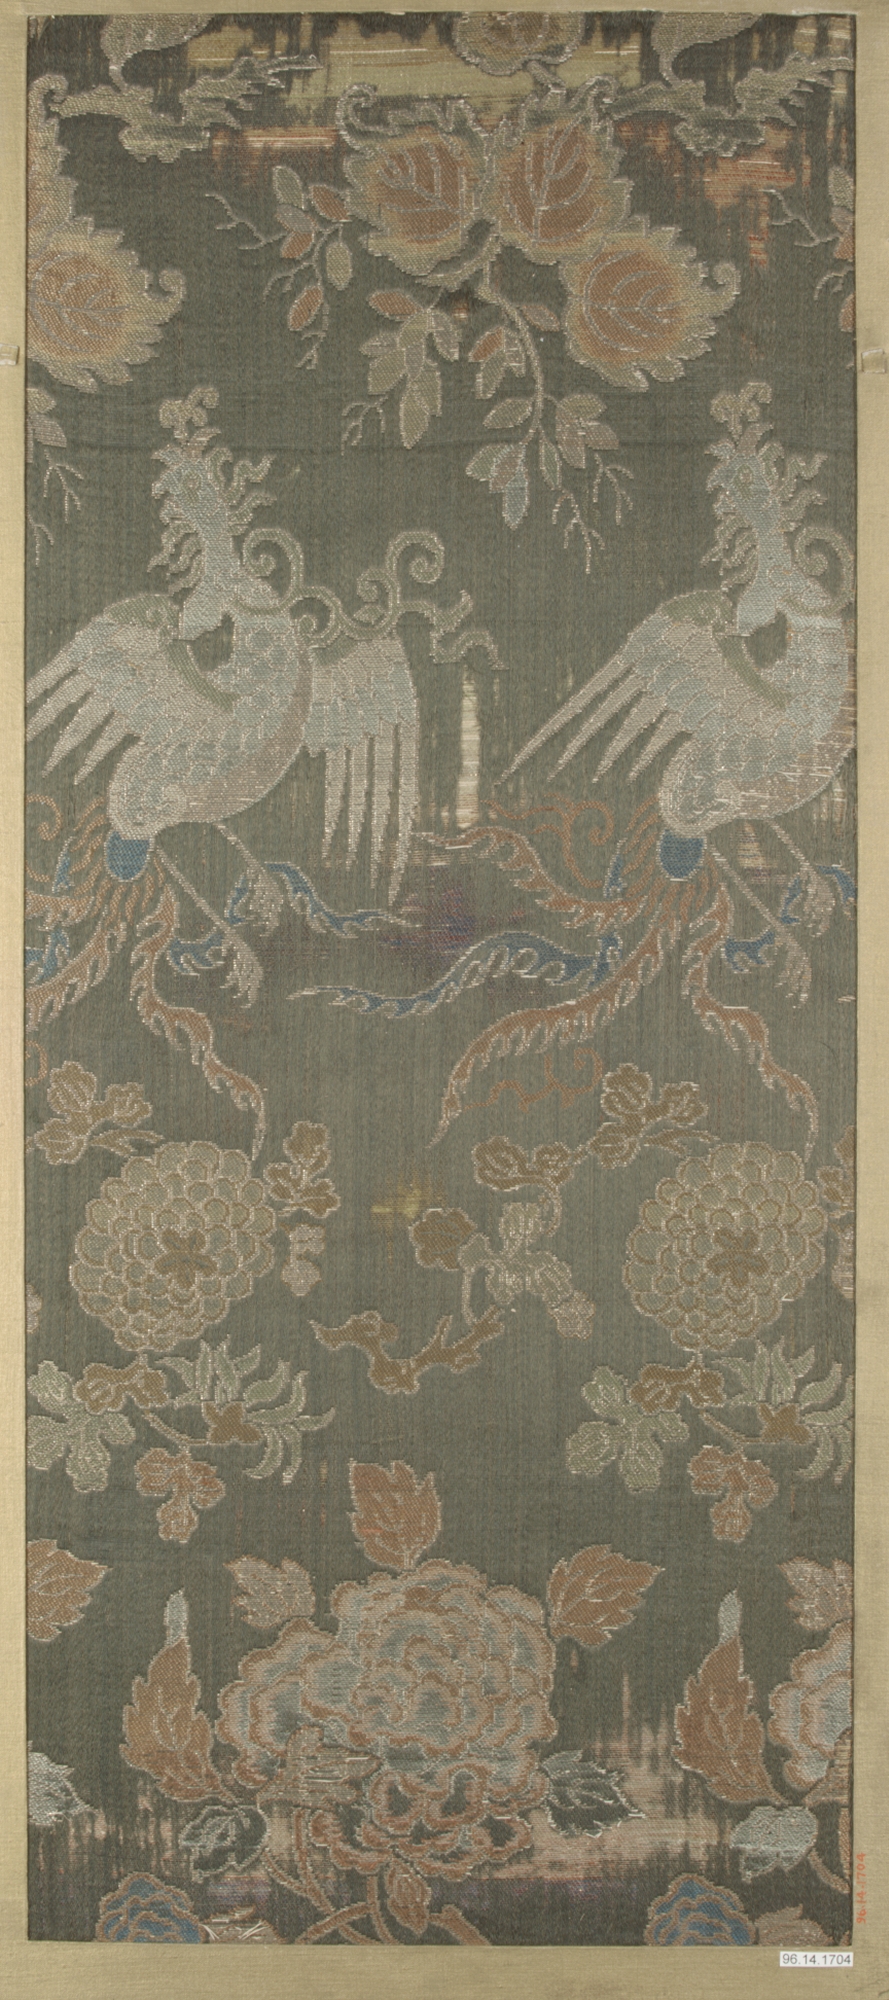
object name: piece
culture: japanese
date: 1701-1900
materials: silk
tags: birds